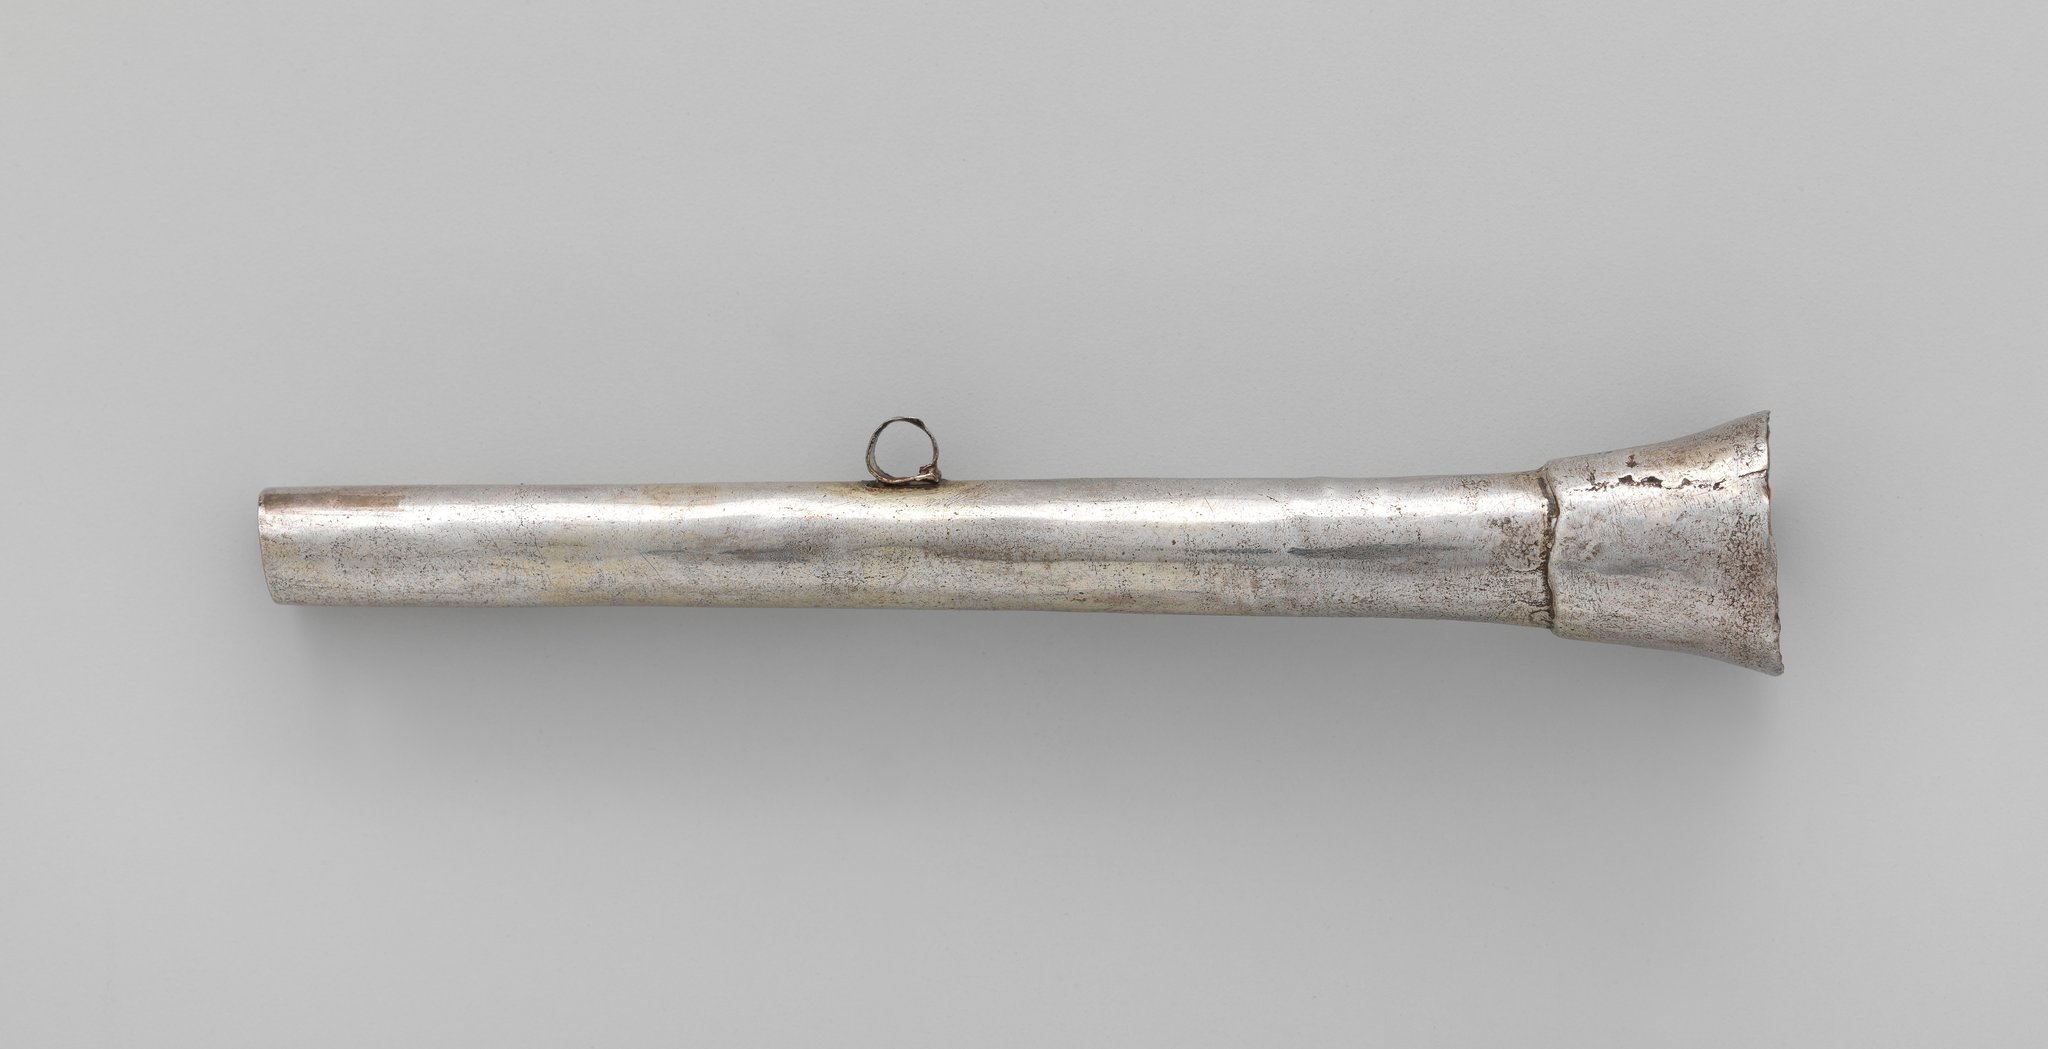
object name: horn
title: Miniature horn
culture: chancay or chimú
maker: chimú or chancay artist(s)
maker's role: artist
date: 1300-1470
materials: silver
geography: peru